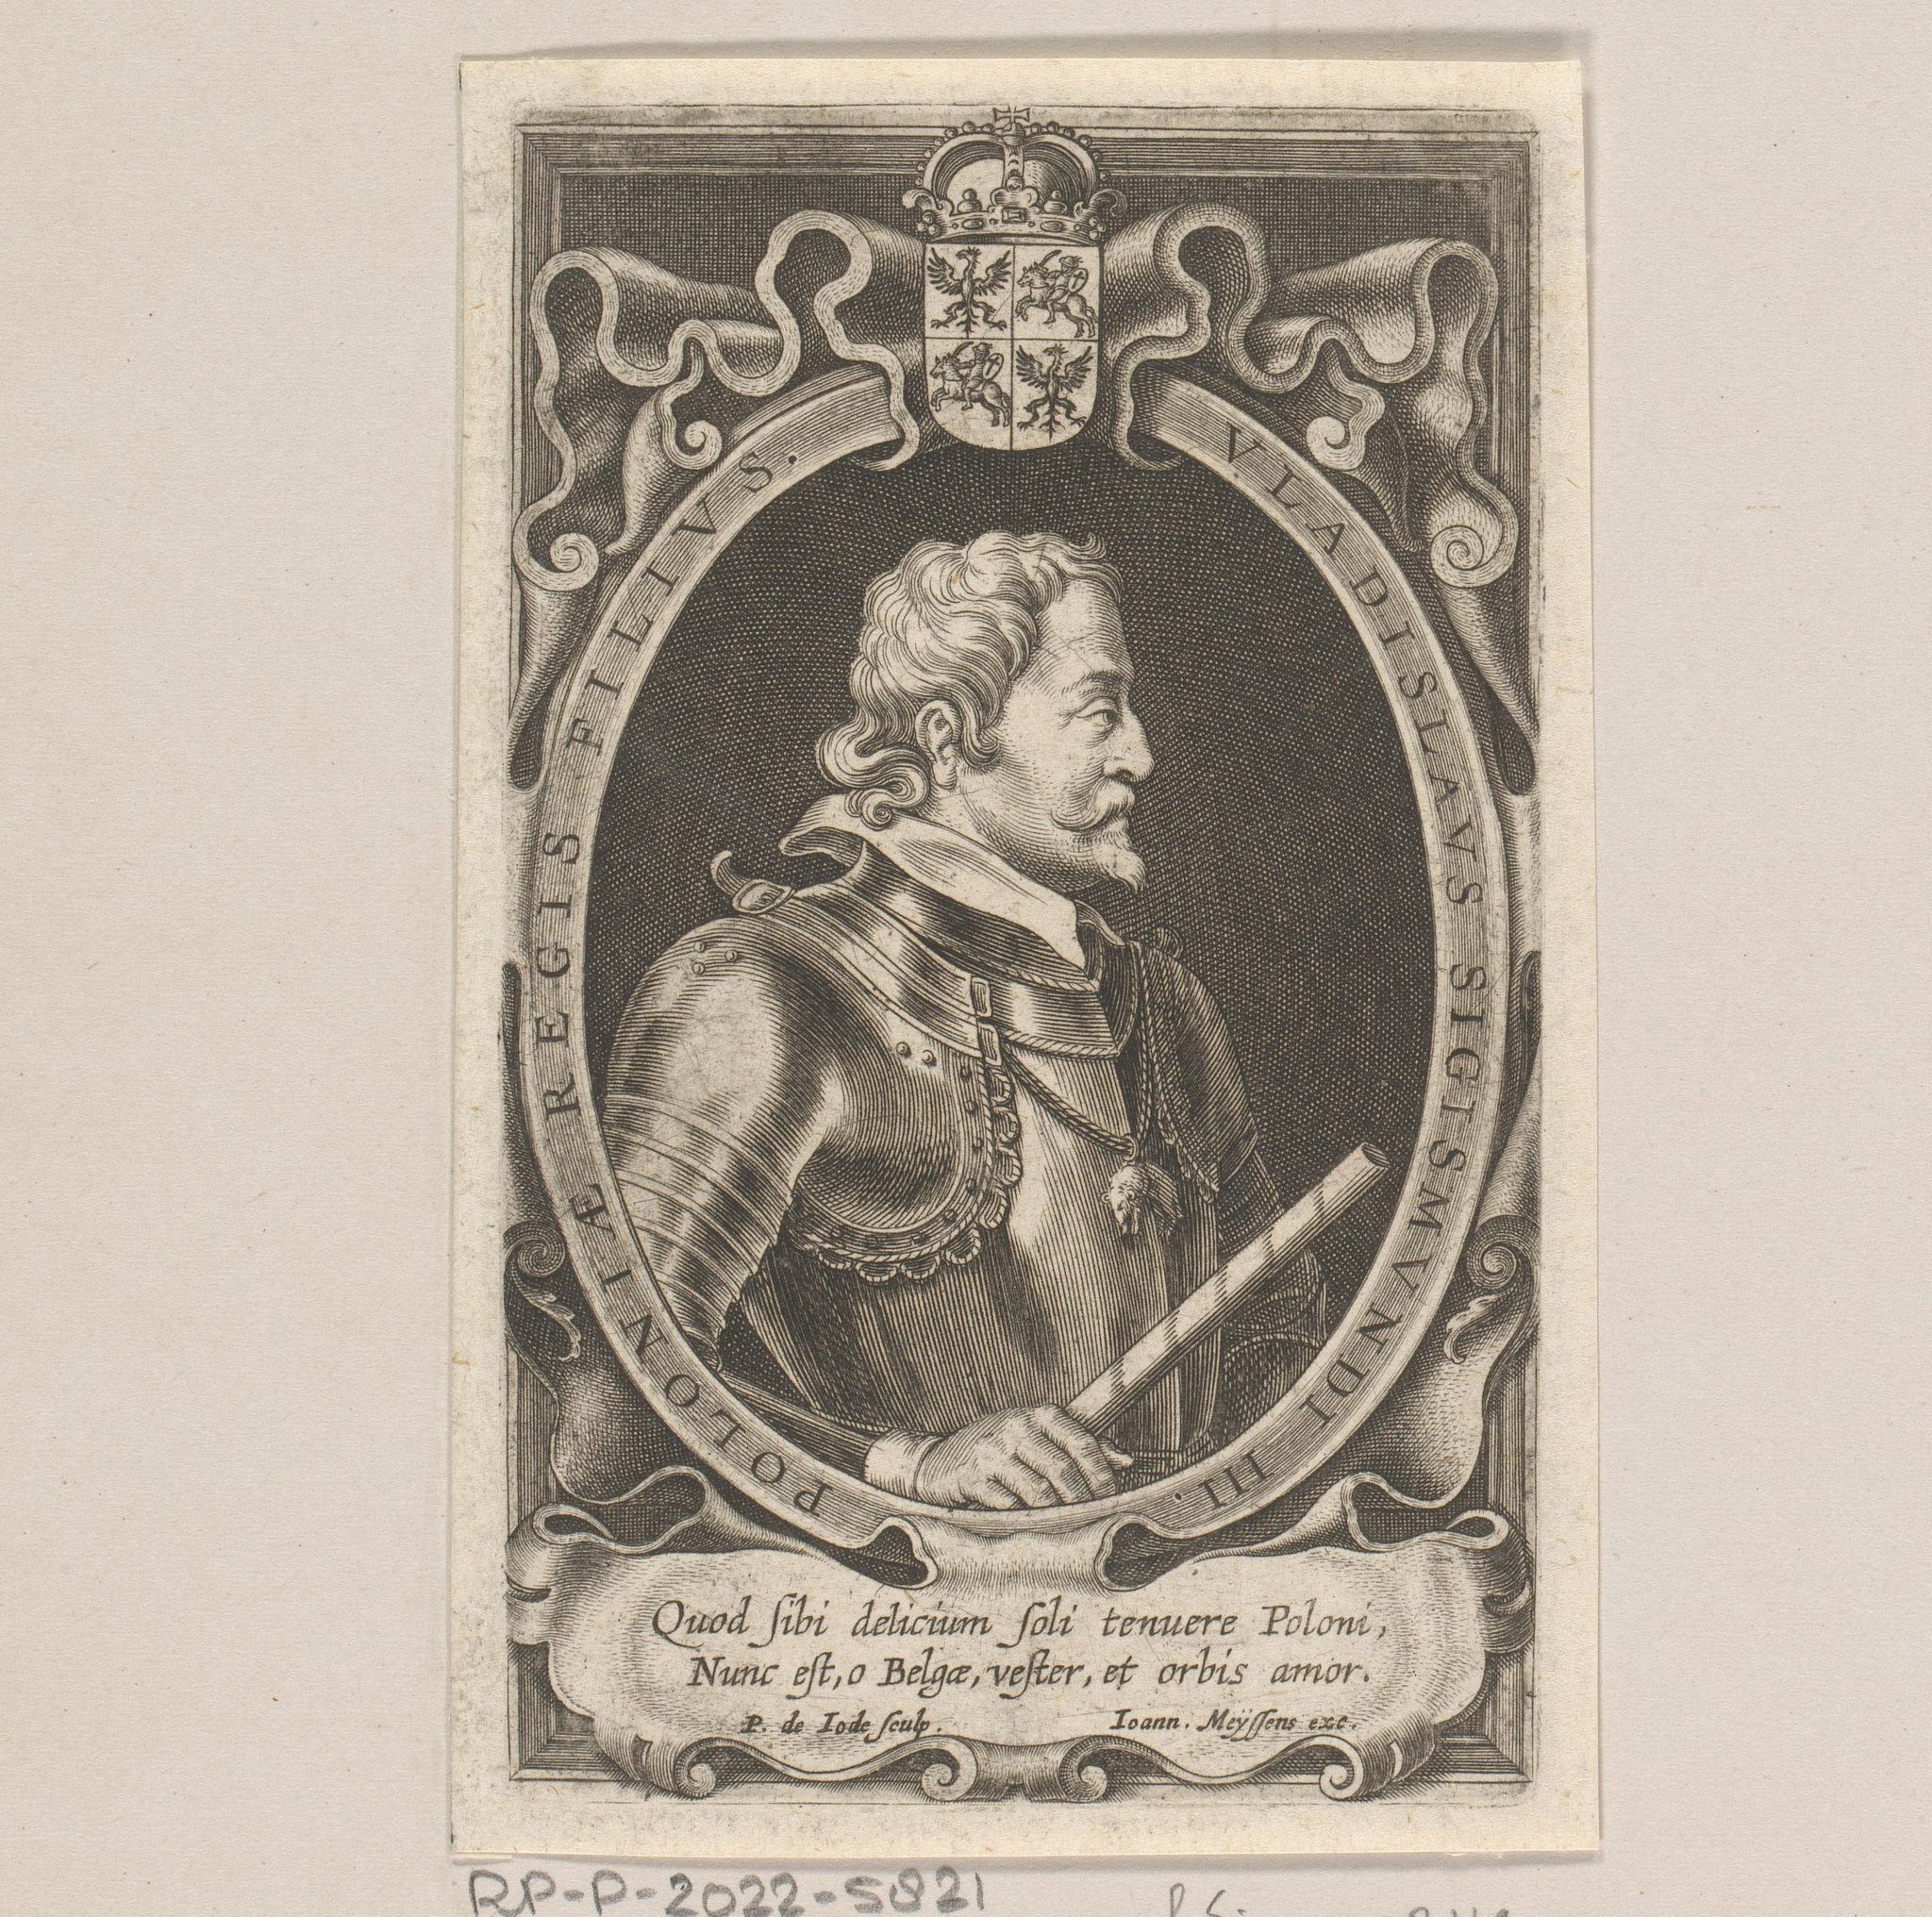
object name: print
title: Portret van Wladislaus IV van Polen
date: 1640-1670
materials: paper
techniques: engraving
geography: antwerp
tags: wladislaus wasa (iv), coat of arms (symbol of sovereignty), historical persons, knighthood order of the golden fleece, ruler, sovereign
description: Met tweeregelig onderschrift in het Latijn en tekst in het Latijn rondom het portret.